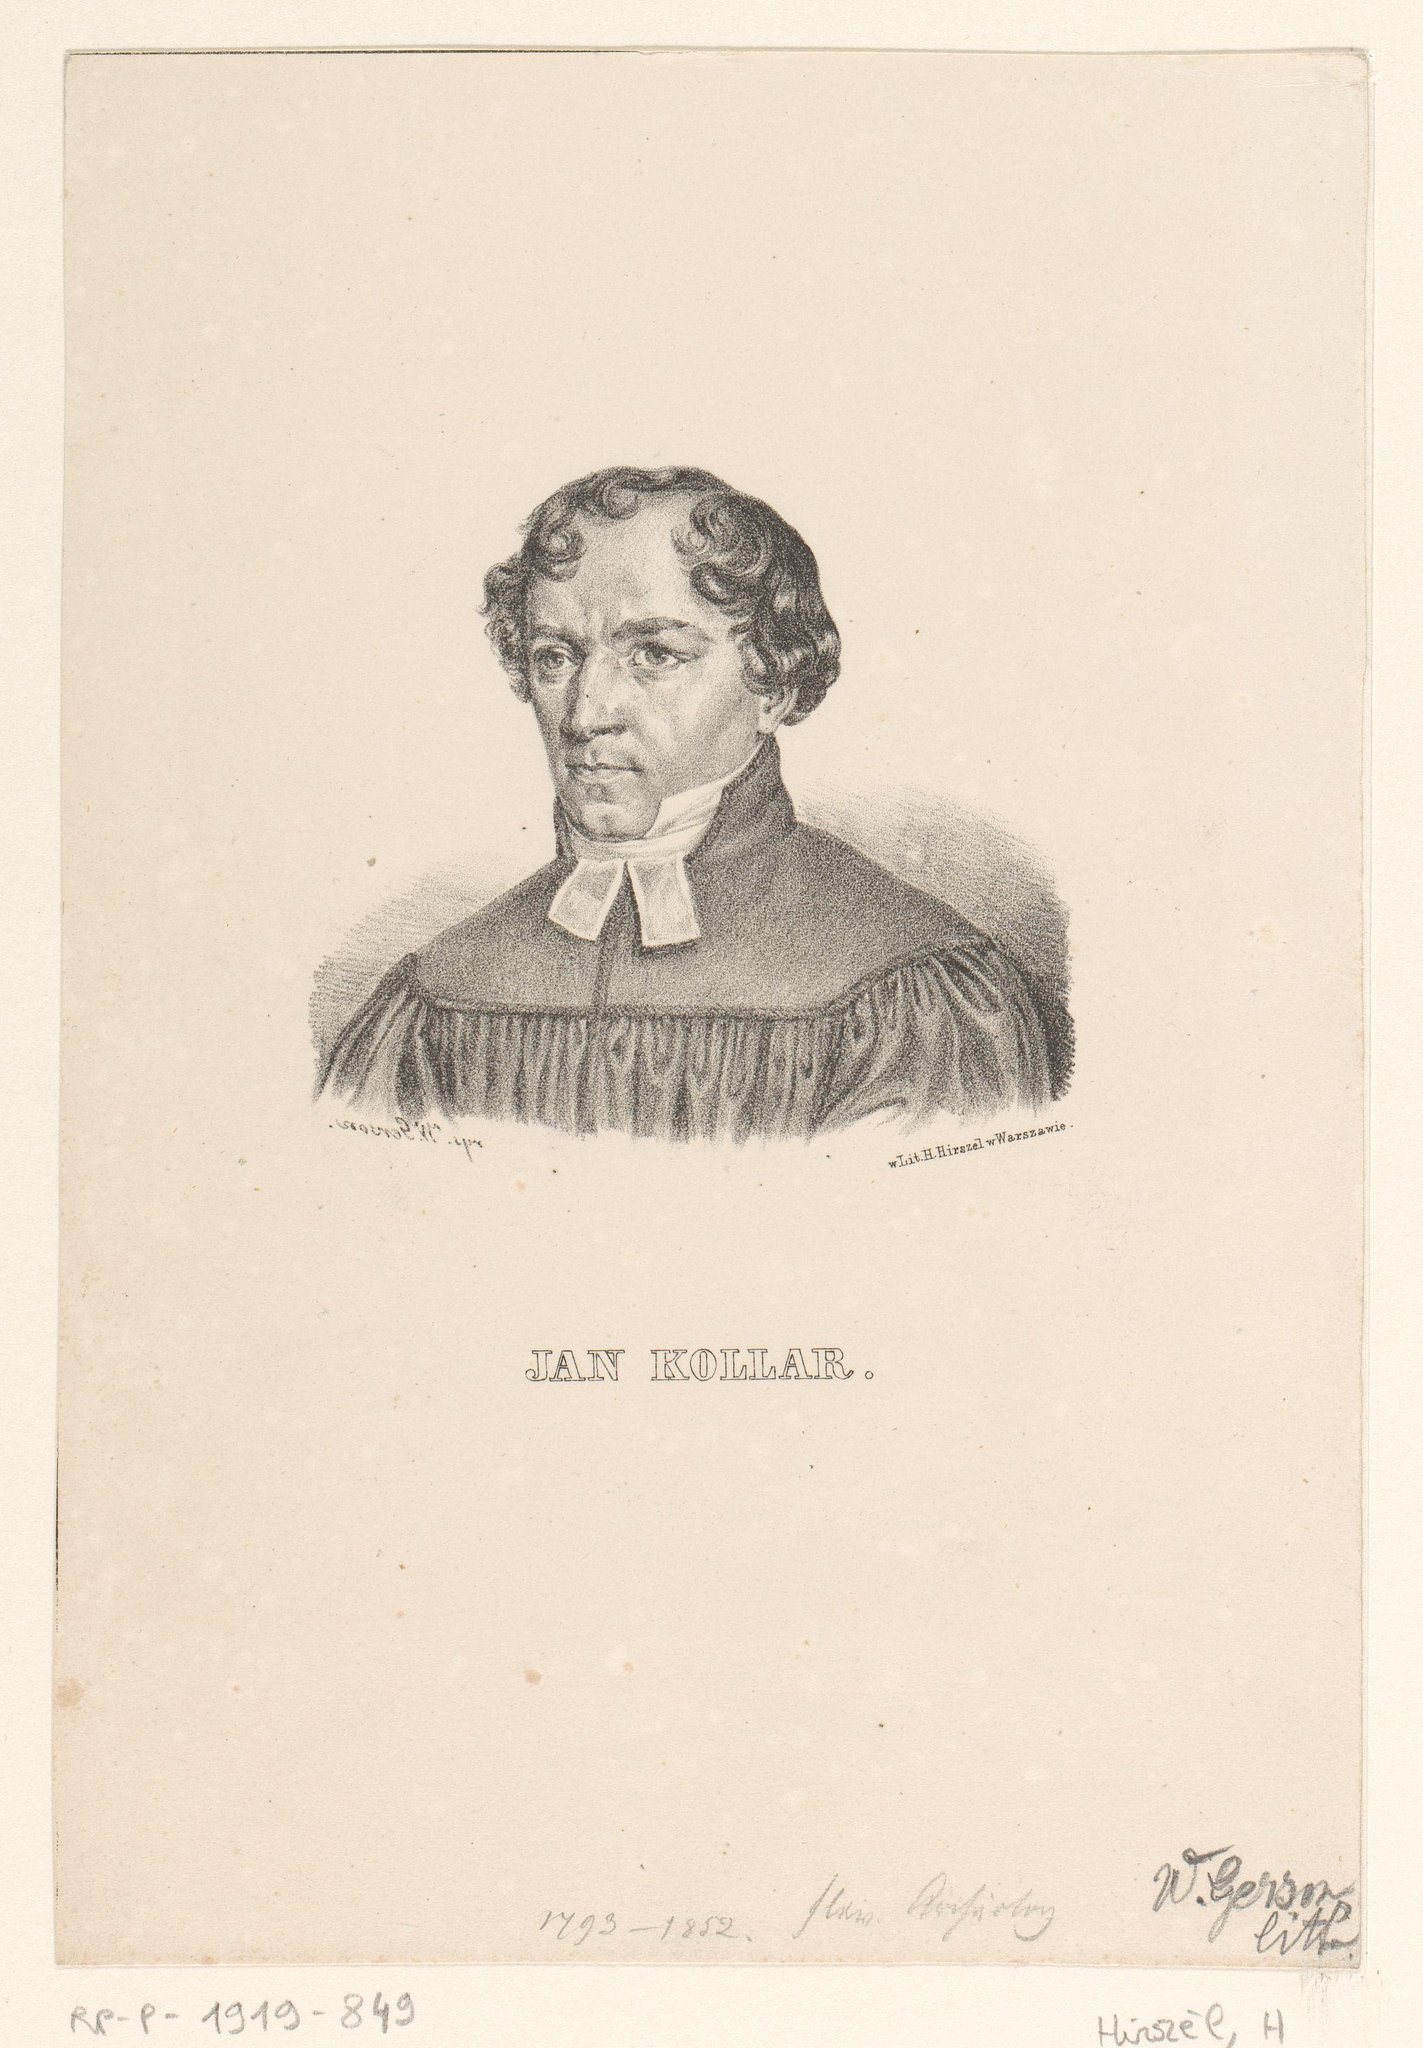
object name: print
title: Jan Kollar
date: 1841-1901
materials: paper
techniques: lithograph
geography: warsaw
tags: adult man, historical persons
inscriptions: collector's mark: Lugt 2228